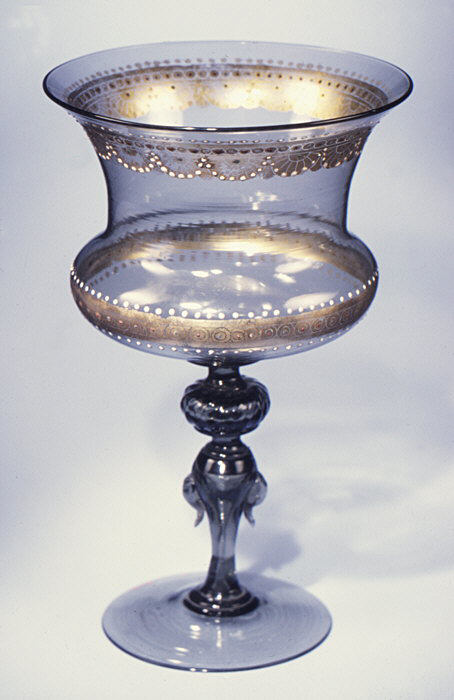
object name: goblet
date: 1801-1900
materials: glass